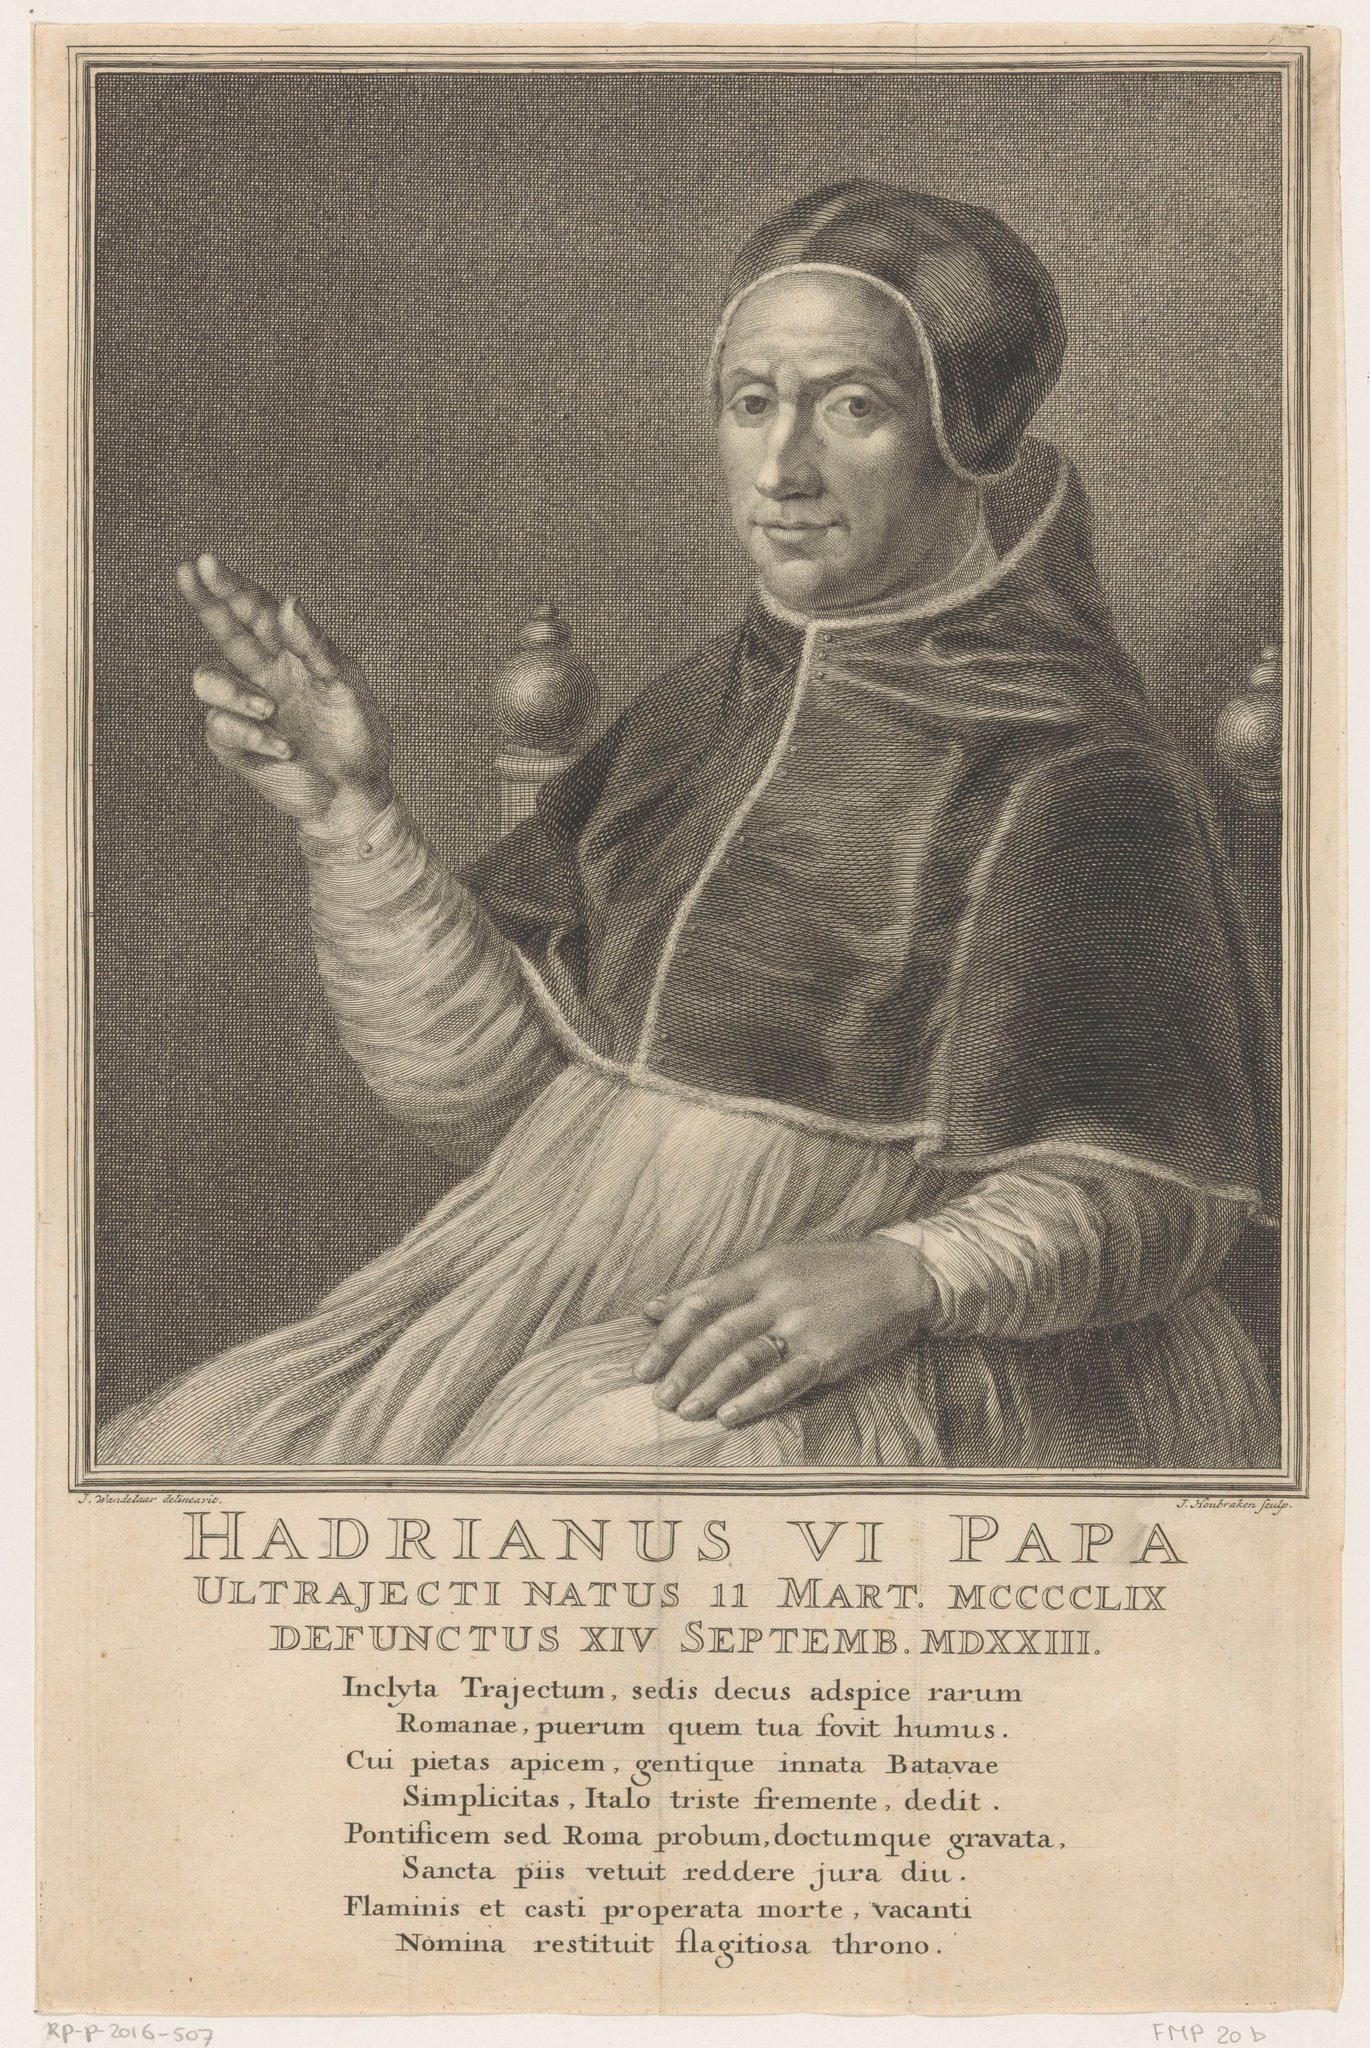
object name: print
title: Portret van paus Adrianus VI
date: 1710-1780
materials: paper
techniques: engraving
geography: amsterdam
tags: utrecht, rome, clergyman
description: Portret van paus Adrianus VI. Hij maakt een zegenend gebaar met zijn rechterhand. In de ondermarge zijn naam en titel, zijn geboorteplaats en geboortedatum, zijn sterfplaats en sterfdatum en acht regels Latijnse tekst.